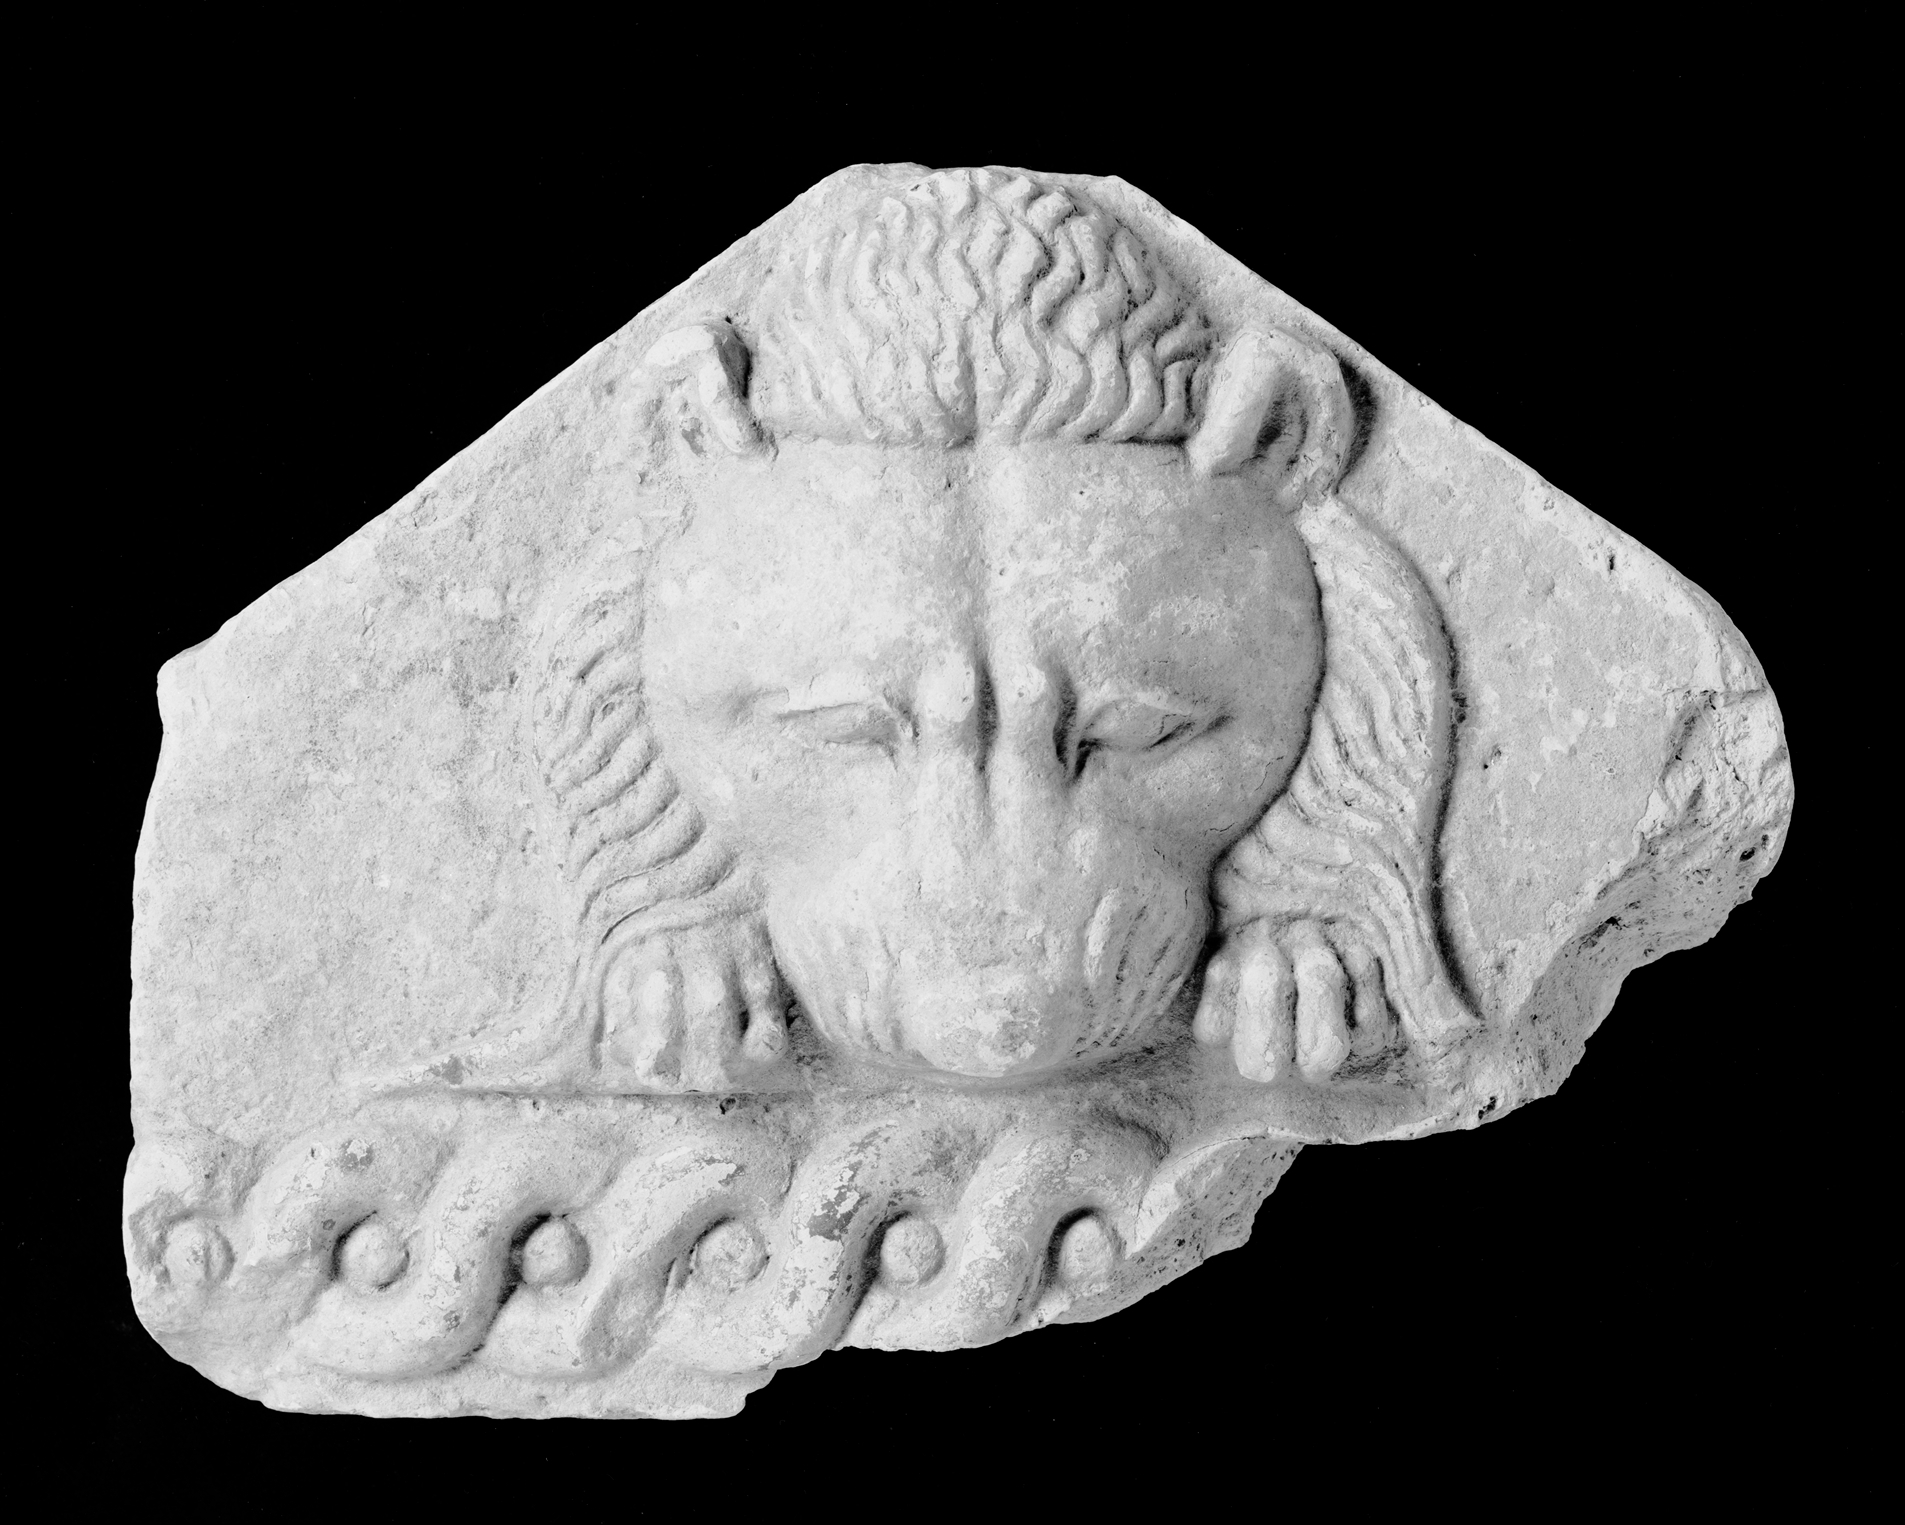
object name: antefix, lion mask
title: Terracotta antefix with lion's head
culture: east greek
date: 534-501 BCE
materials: terracotta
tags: lions